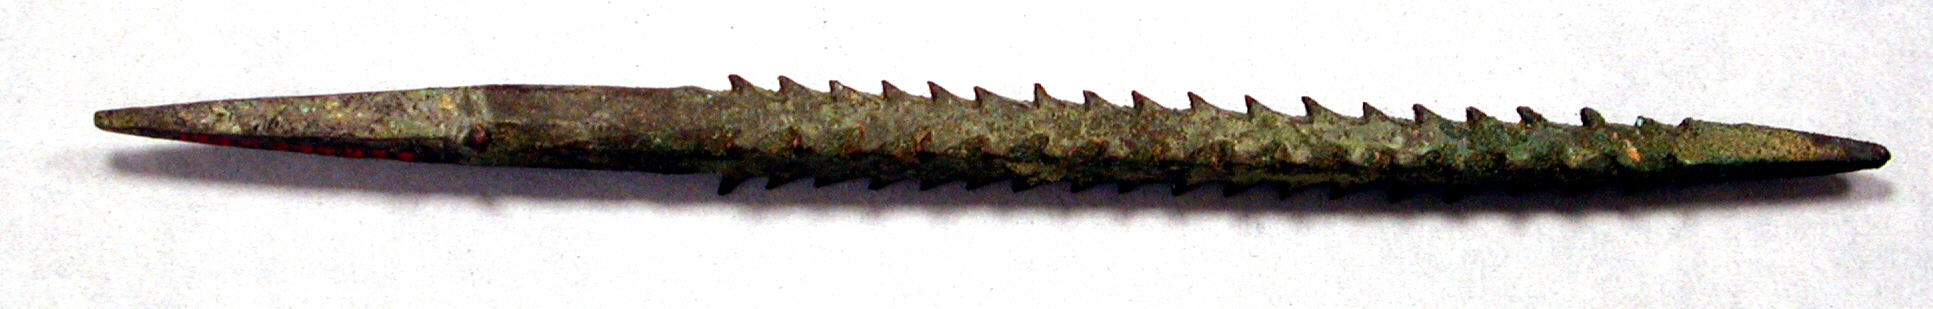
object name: point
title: Barbed Point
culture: vicús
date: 300 BCE-200 CE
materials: copper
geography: peru